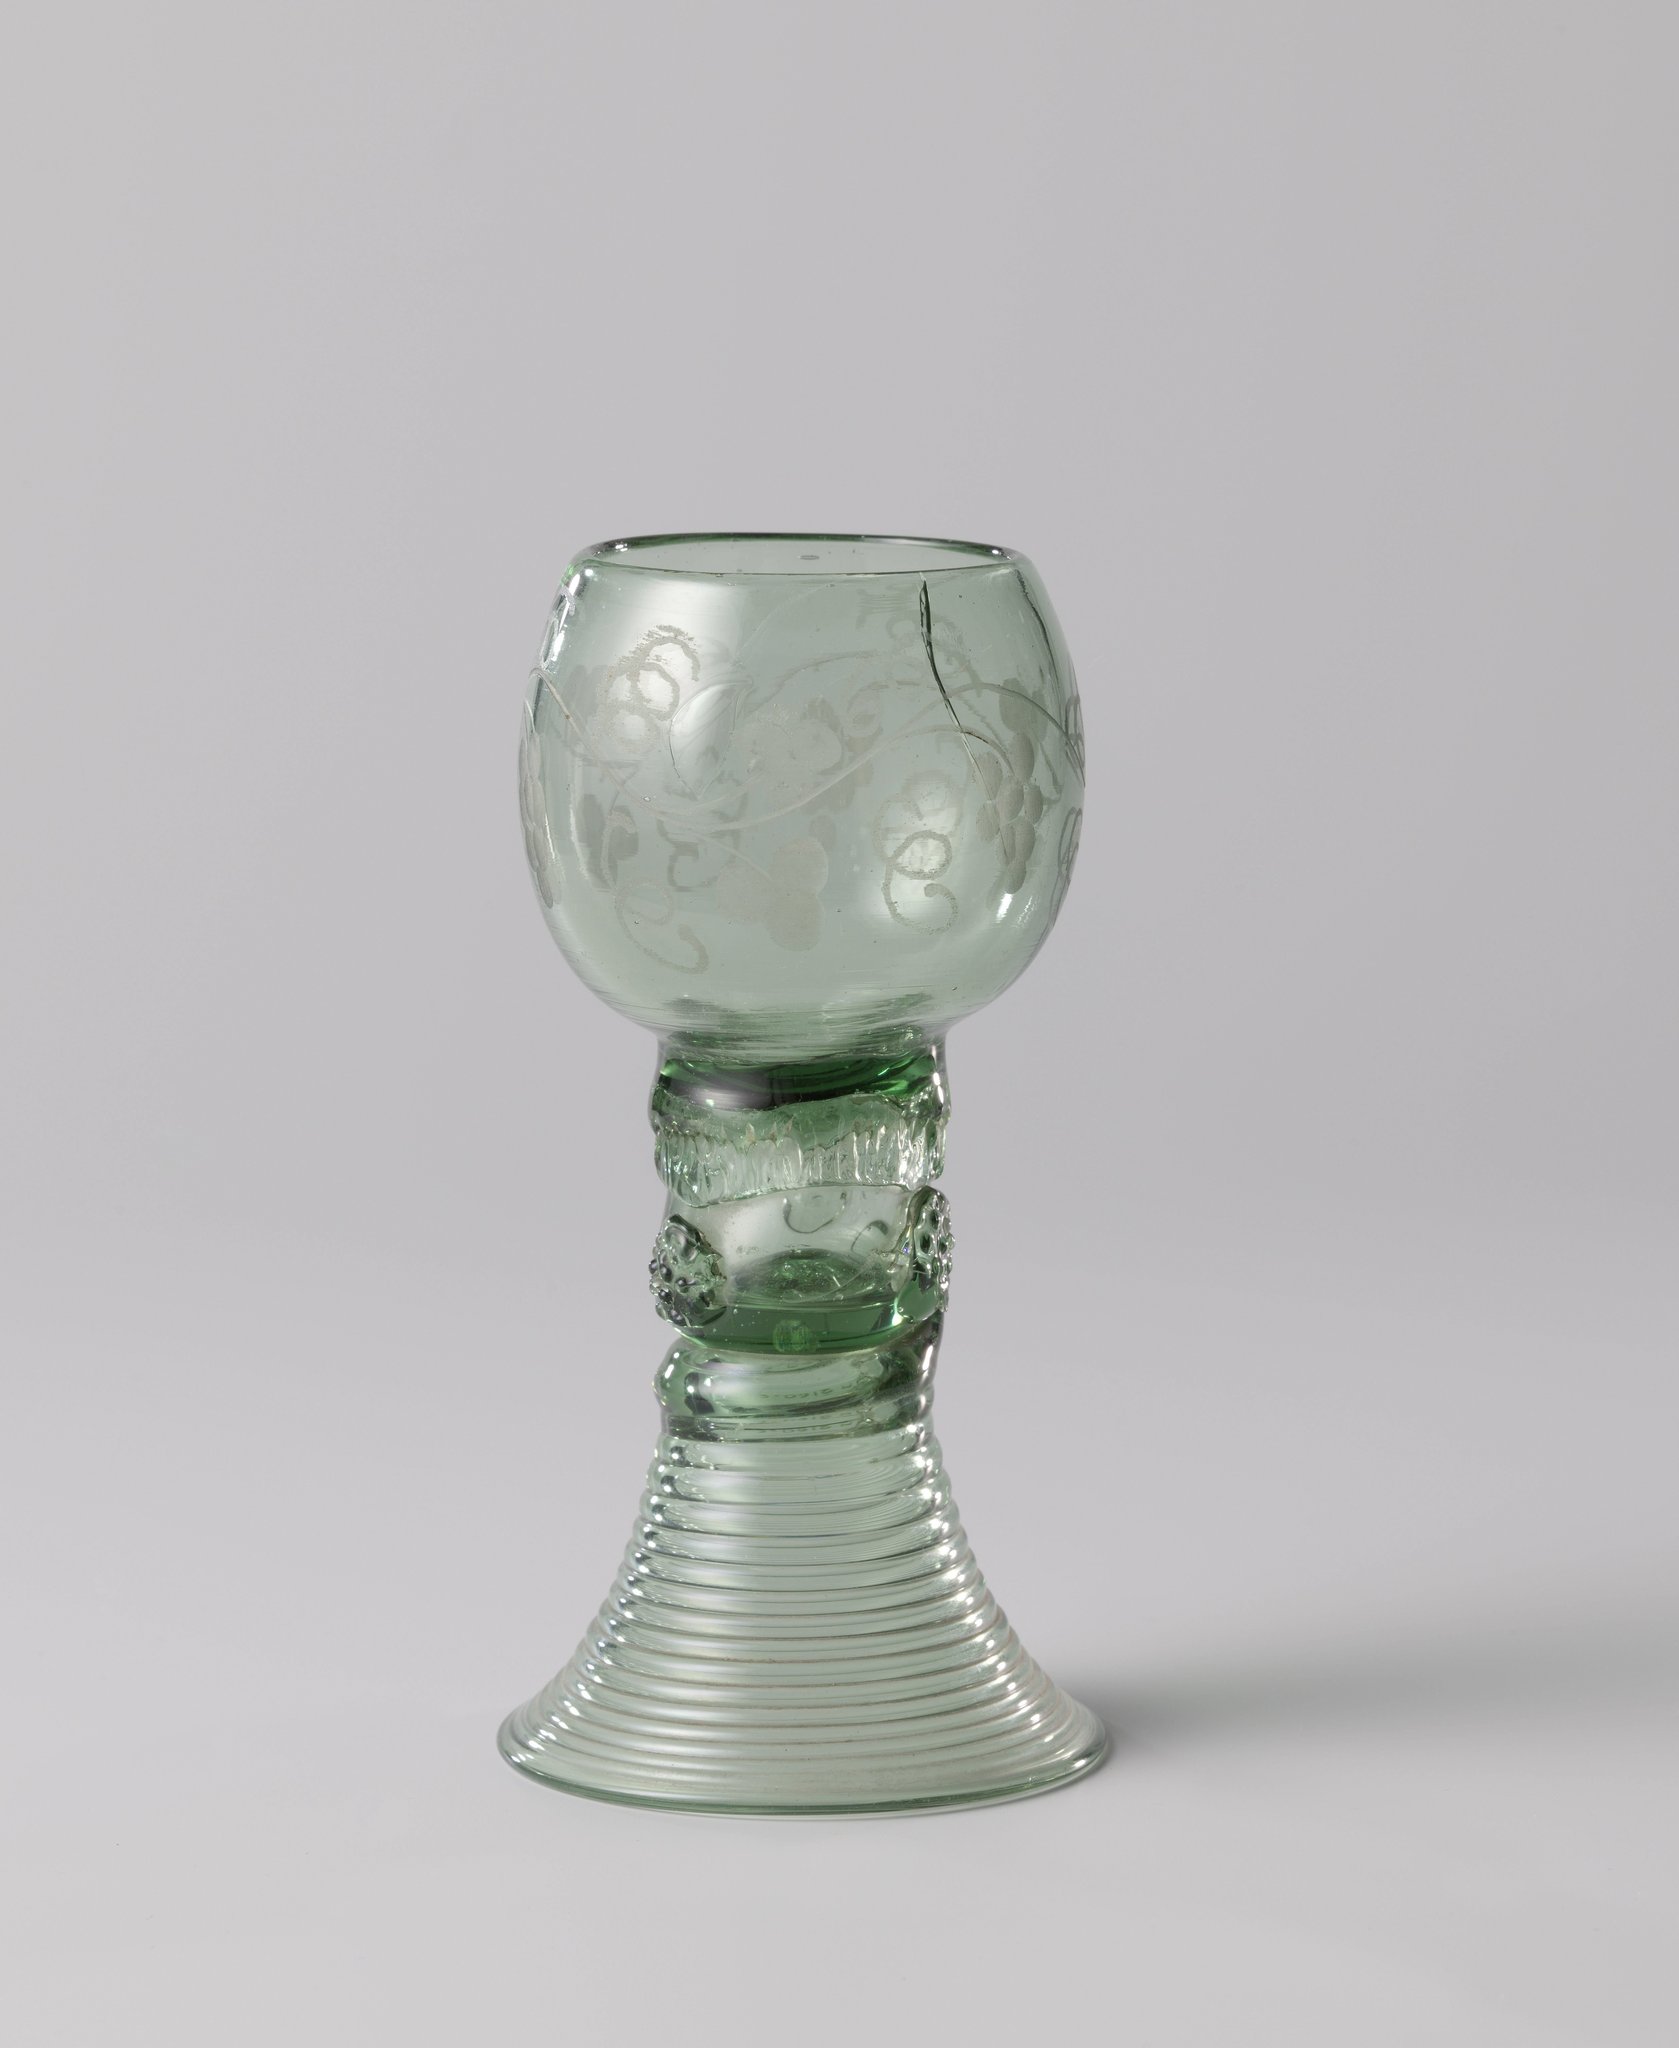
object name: roemer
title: Roemer met wijnranken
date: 1750-1810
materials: glass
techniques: glassblowing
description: Roemer met ingestoken bodem op hoge, uit een draad gesponnen voet. De bolvormige kelk en de stam, die bezet is met drie braamnoppen, zijn afzonderlijk geblazen. Op de kelk is met het rad een wijnrank gegraveerd. De overgang van de kelk naar stam wordt aangegeven door een geribde draad.